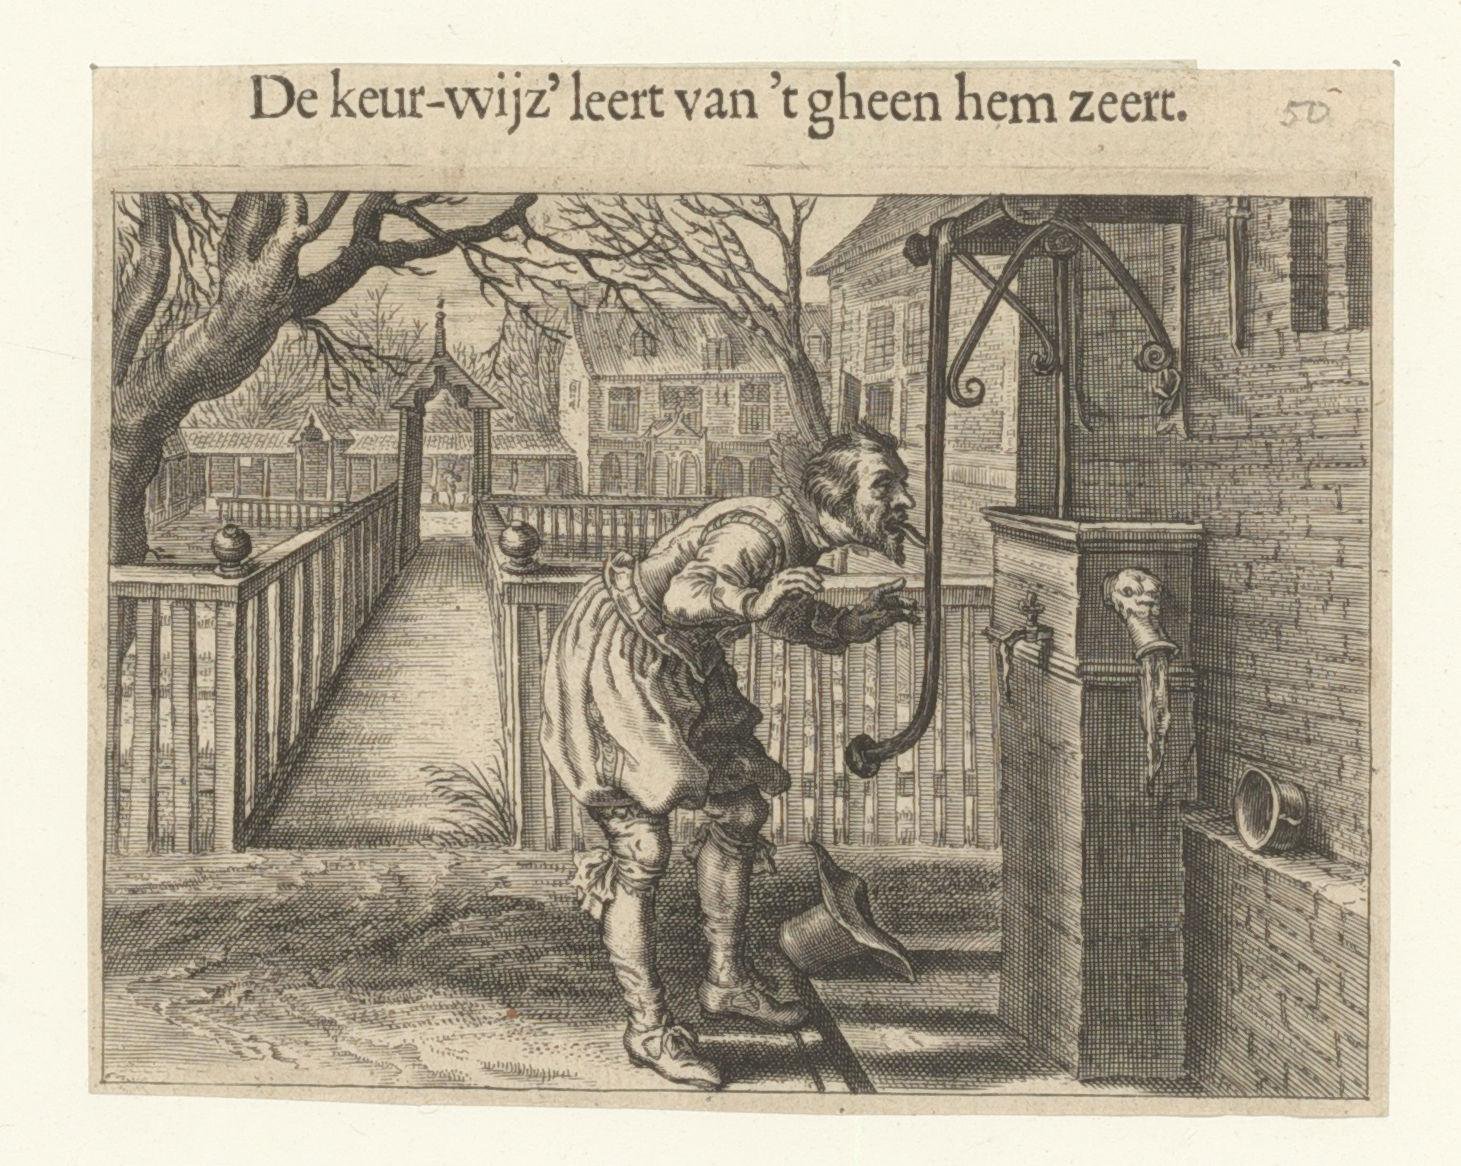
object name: book illustration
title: Man vriest met tong aan de waterpomp vast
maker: Anonymous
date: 1624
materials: paper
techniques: engraving, letterpress printing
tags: fenced or walled garden; 'hortus conclusus', winter, 'hyems'; 'inverno' (ripa), adult man, proverbs, sayings, etc., tongue stuck out, utilitarian, public pump or water fountain, docility; 'docilità' (ripa)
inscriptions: stamp, collector's mark: Lugt 1641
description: Prent uit: Brune, Johan de. Zinne-werck, Voor-ghesyelt in Beelden, Ghedichten, ende breeder uyt-legginghen (...). Amsterdam: Evertsen Kloppenburch, 1624. Prent ook gebruikt in latere edities (1636 en 1661).